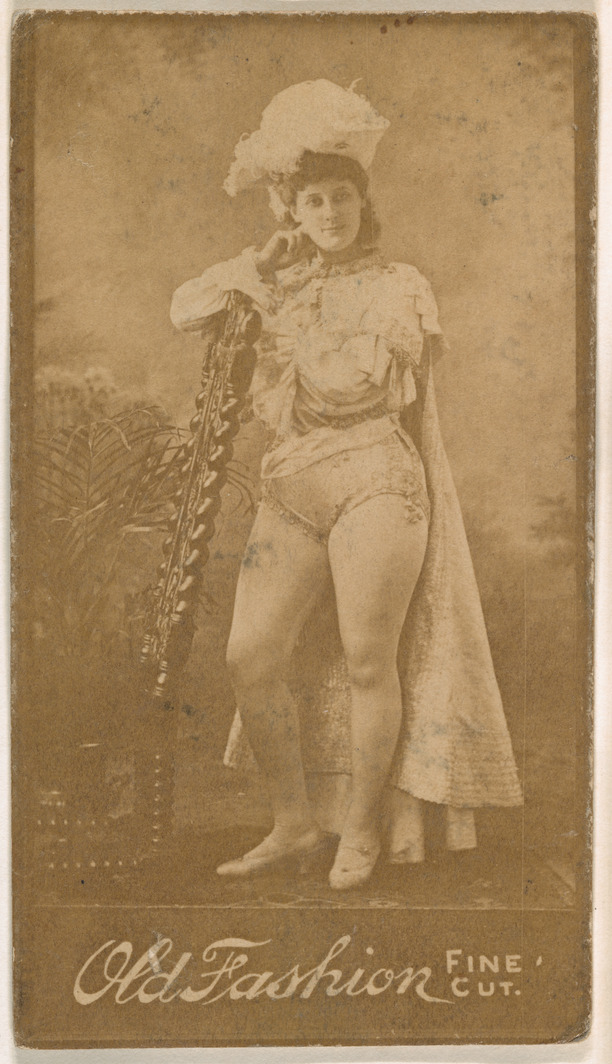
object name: photograph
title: Actress wearing costume with cape, from the Actresses series (N664) promoting Old Fashion Fine Cut Tobacco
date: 1888-1890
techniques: albumen silver print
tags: portraits,women,actresses